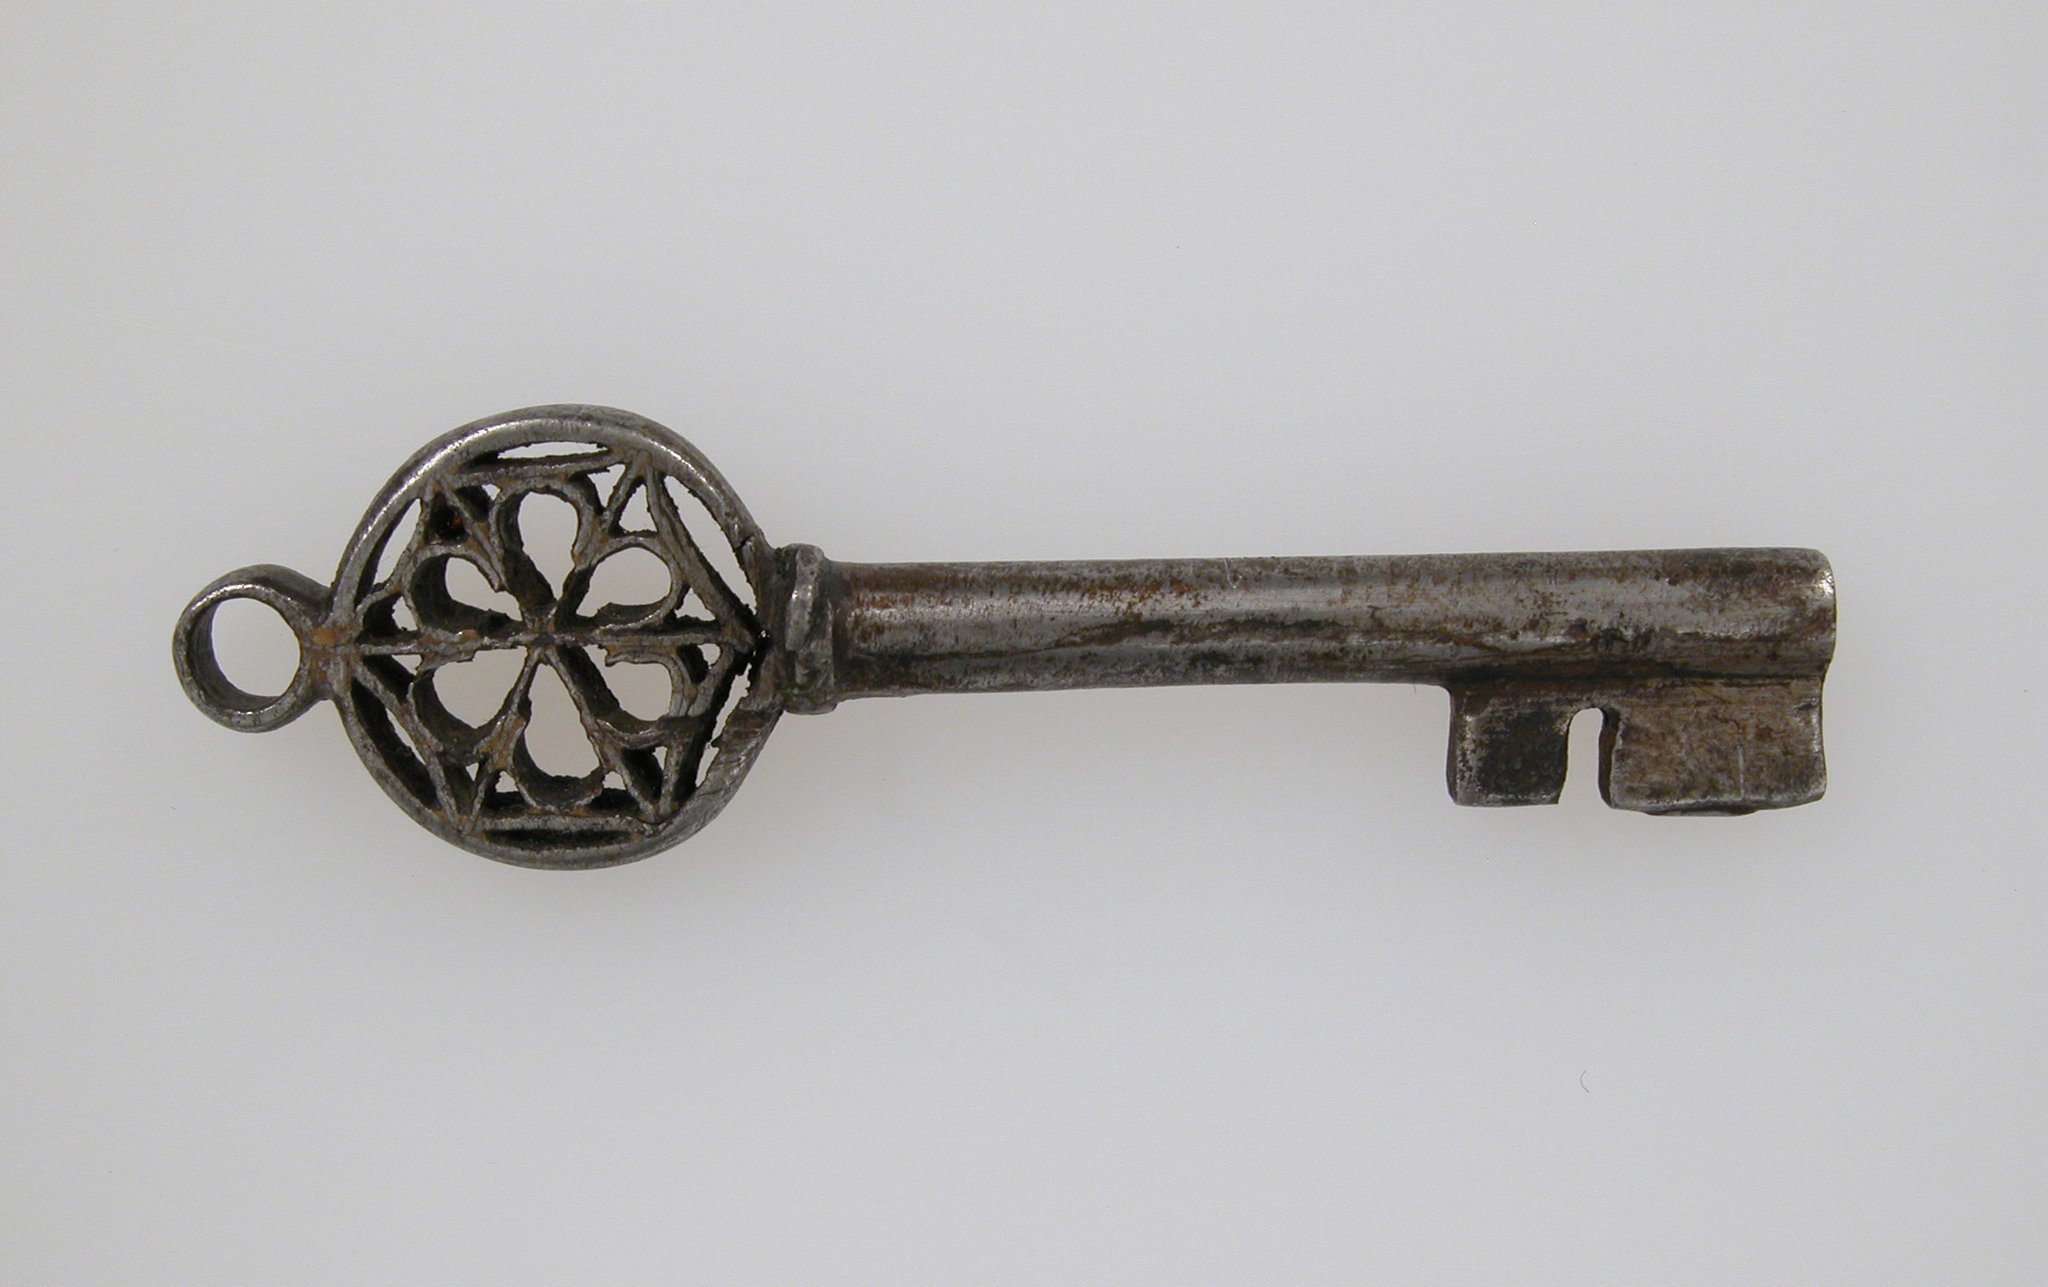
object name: key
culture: german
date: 1401-1600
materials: iron